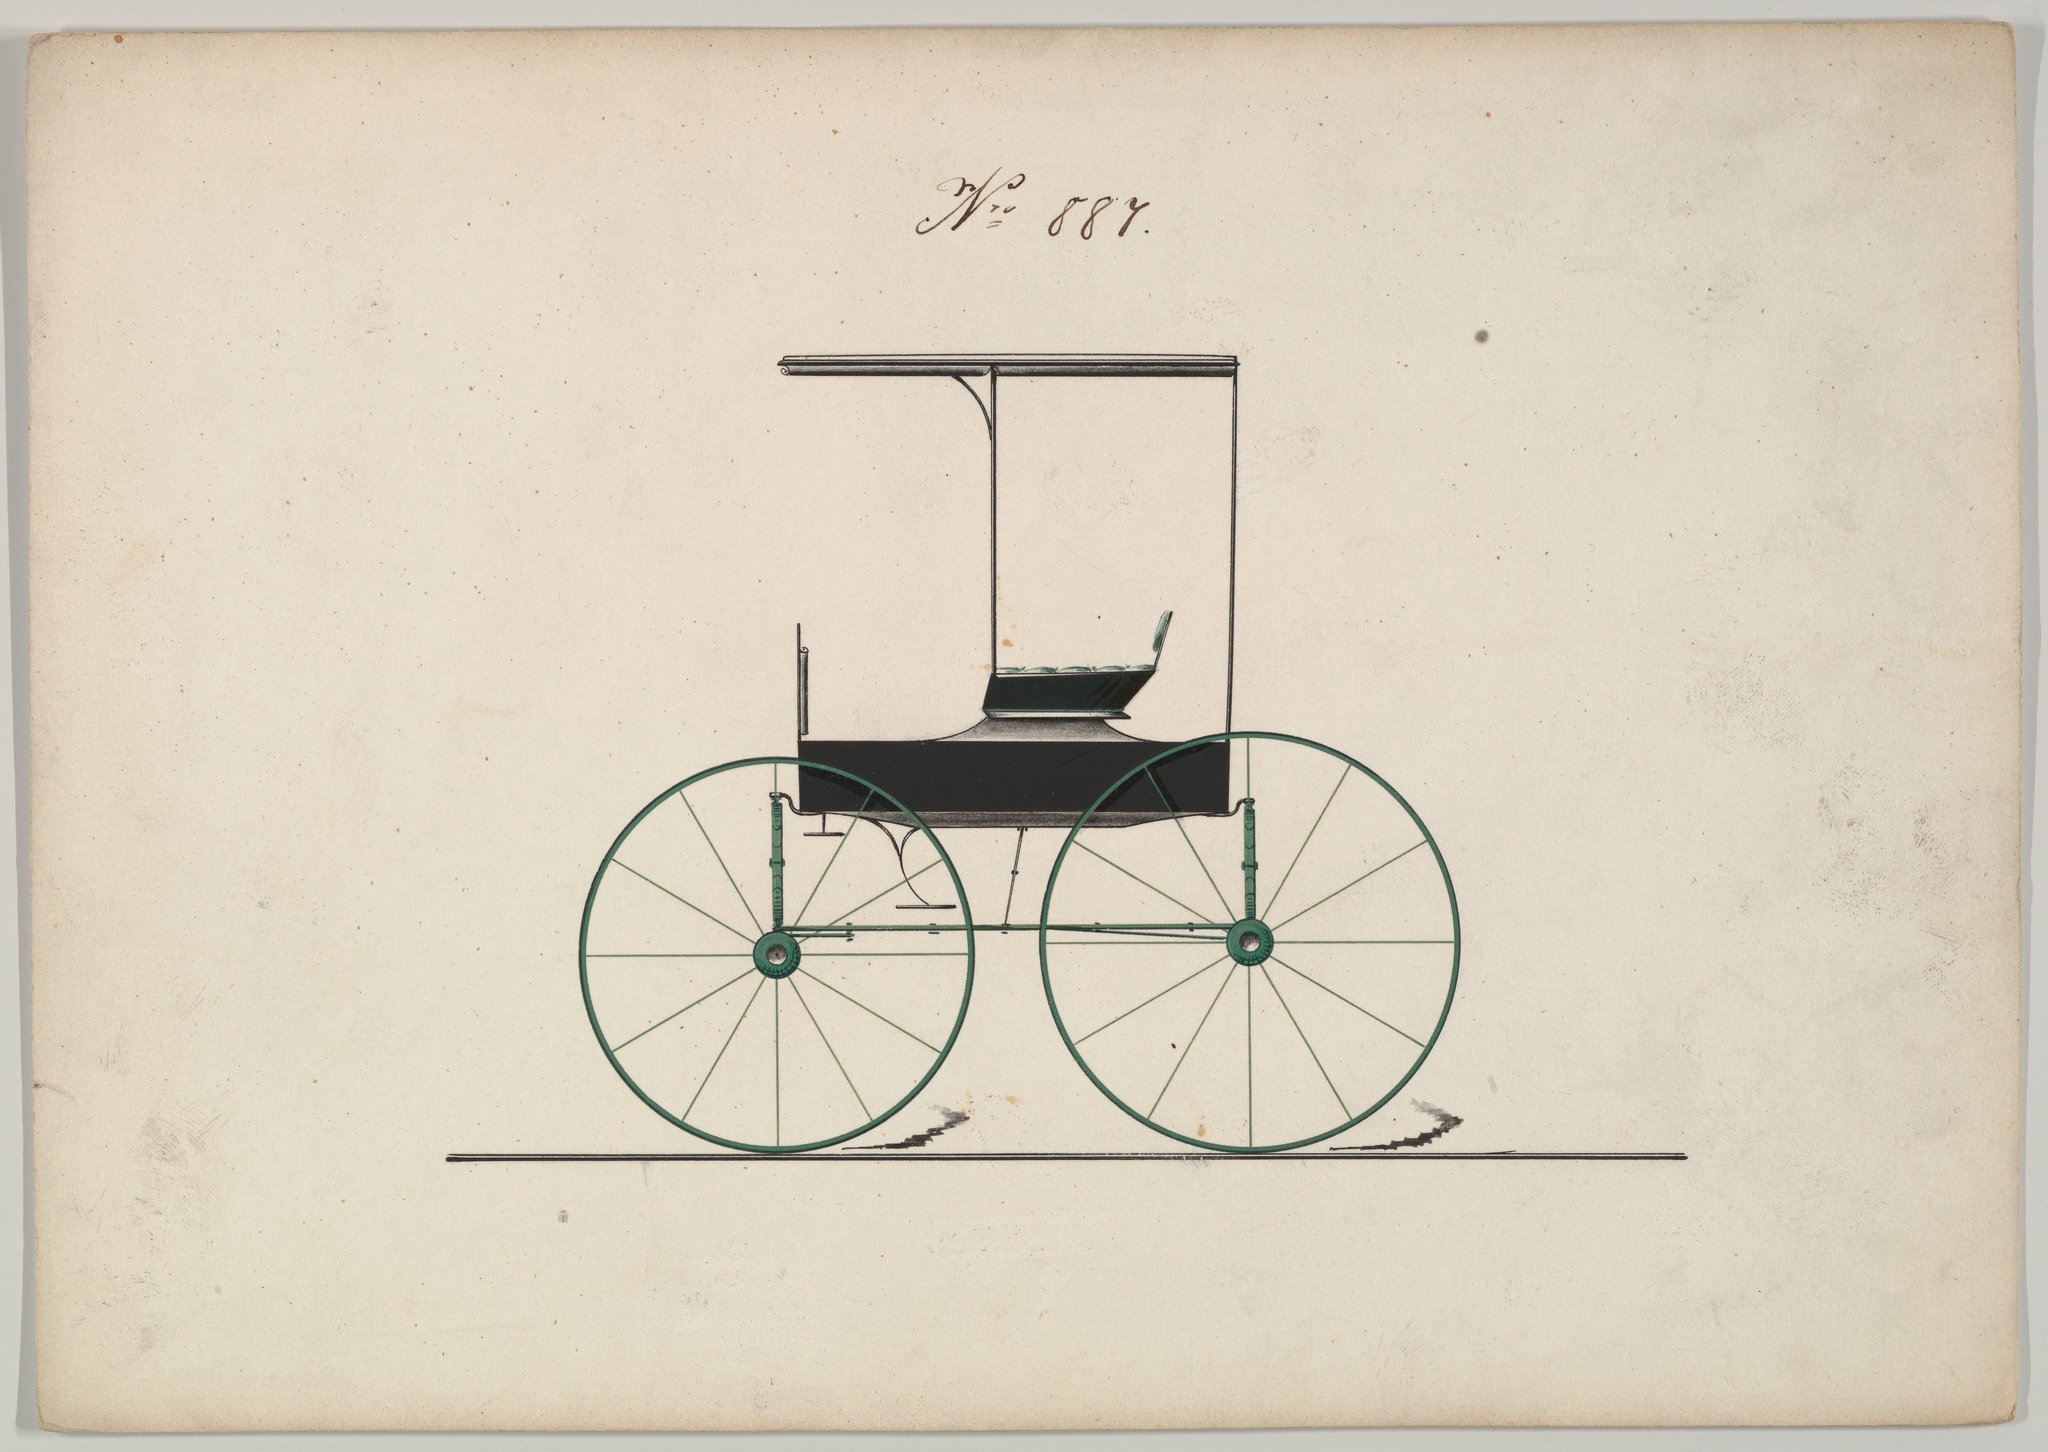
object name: drawing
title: Design for Wagon, no. 887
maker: brewster & co.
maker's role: manufacturer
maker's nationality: american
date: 1860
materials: gouache, gum arabic, ink, watercolor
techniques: pen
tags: carriages